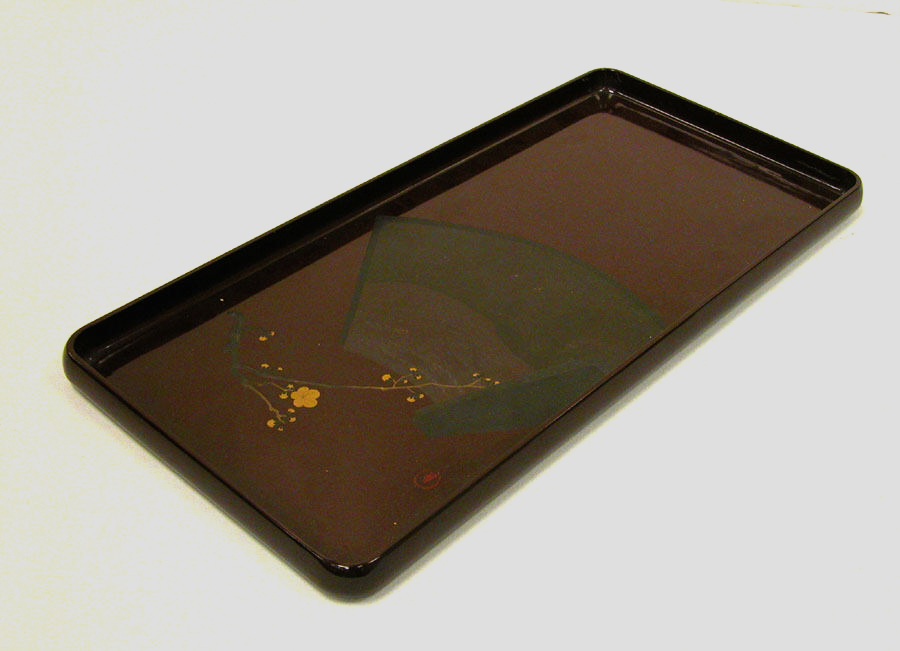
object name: tray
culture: japanese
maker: shibata zeshin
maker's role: artist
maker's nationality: japanese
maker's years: 1807-1891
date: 1801-1900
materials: lacquer